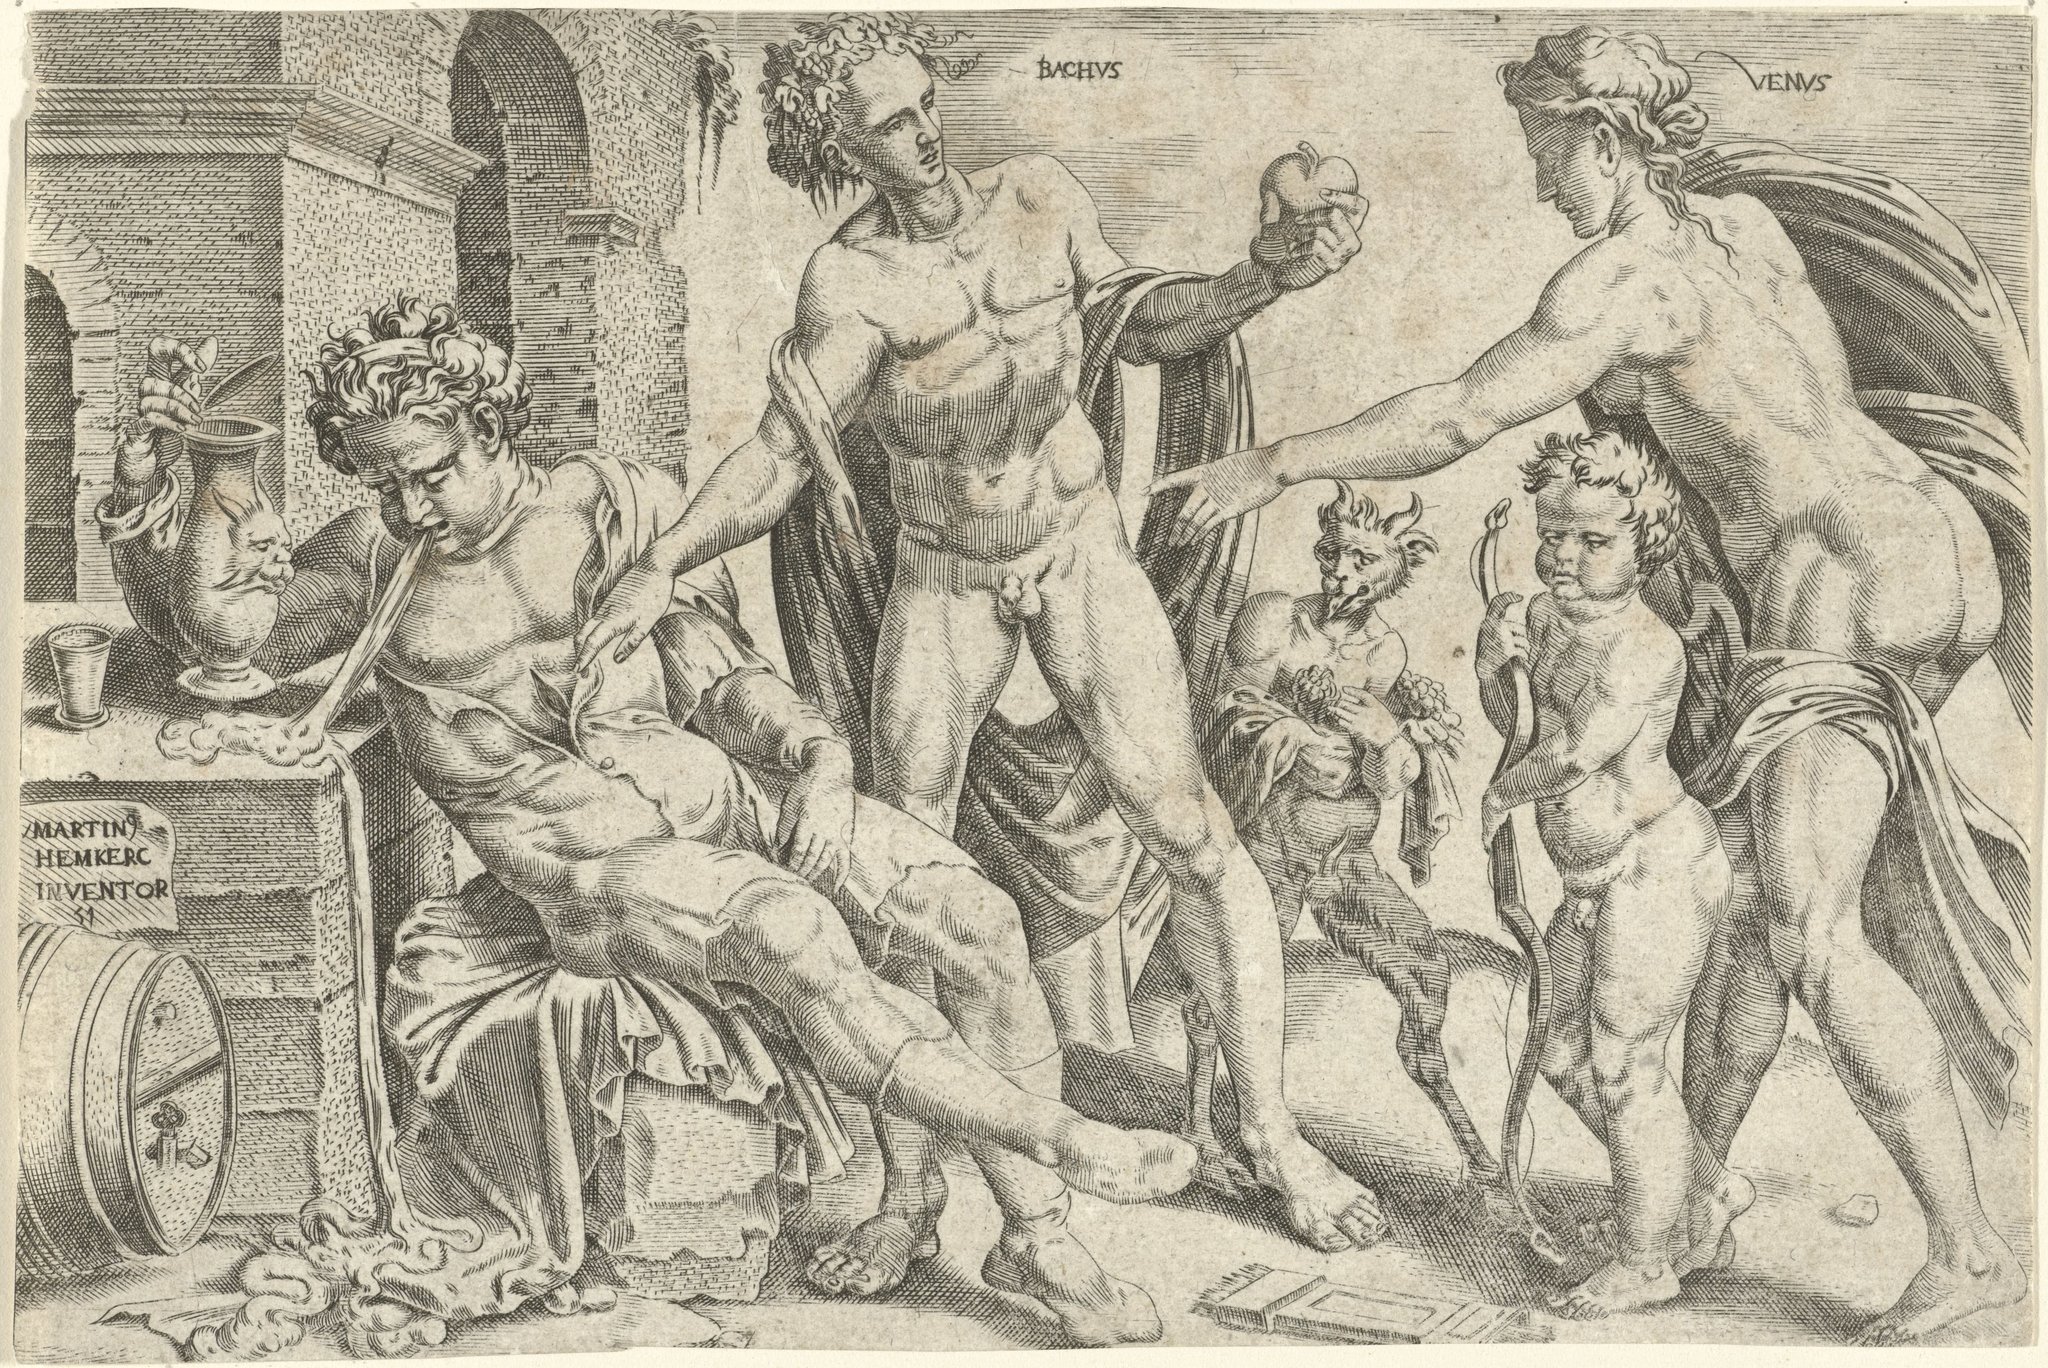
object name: print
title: Gevolgen van dronkenschap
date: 1551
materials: paper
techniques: engraving, etching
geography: haarlem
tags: (story of) bacchus (dionysus), liber, satyr(s) (in general), (story of) cupid, amor (eros), drunkenness, (story of) venus (aphrodite)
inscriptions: collector's mark: Lugt 2228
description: Bacchus, de god van de wijn, heeft het hart gestolen van een dronkaard, die naast hem tegen een tafeltje aanleunt en braakt. In zijn handen een kruik wijn. Bacchus geeft het hart van de dronkaard aan Venus, de godin van de liefde: eenmaal dronken geeft de dronkaard zichzelf over aan lust. Naast Venus staat Cupido. Naast Bacchus een sater met druiven in de hand.